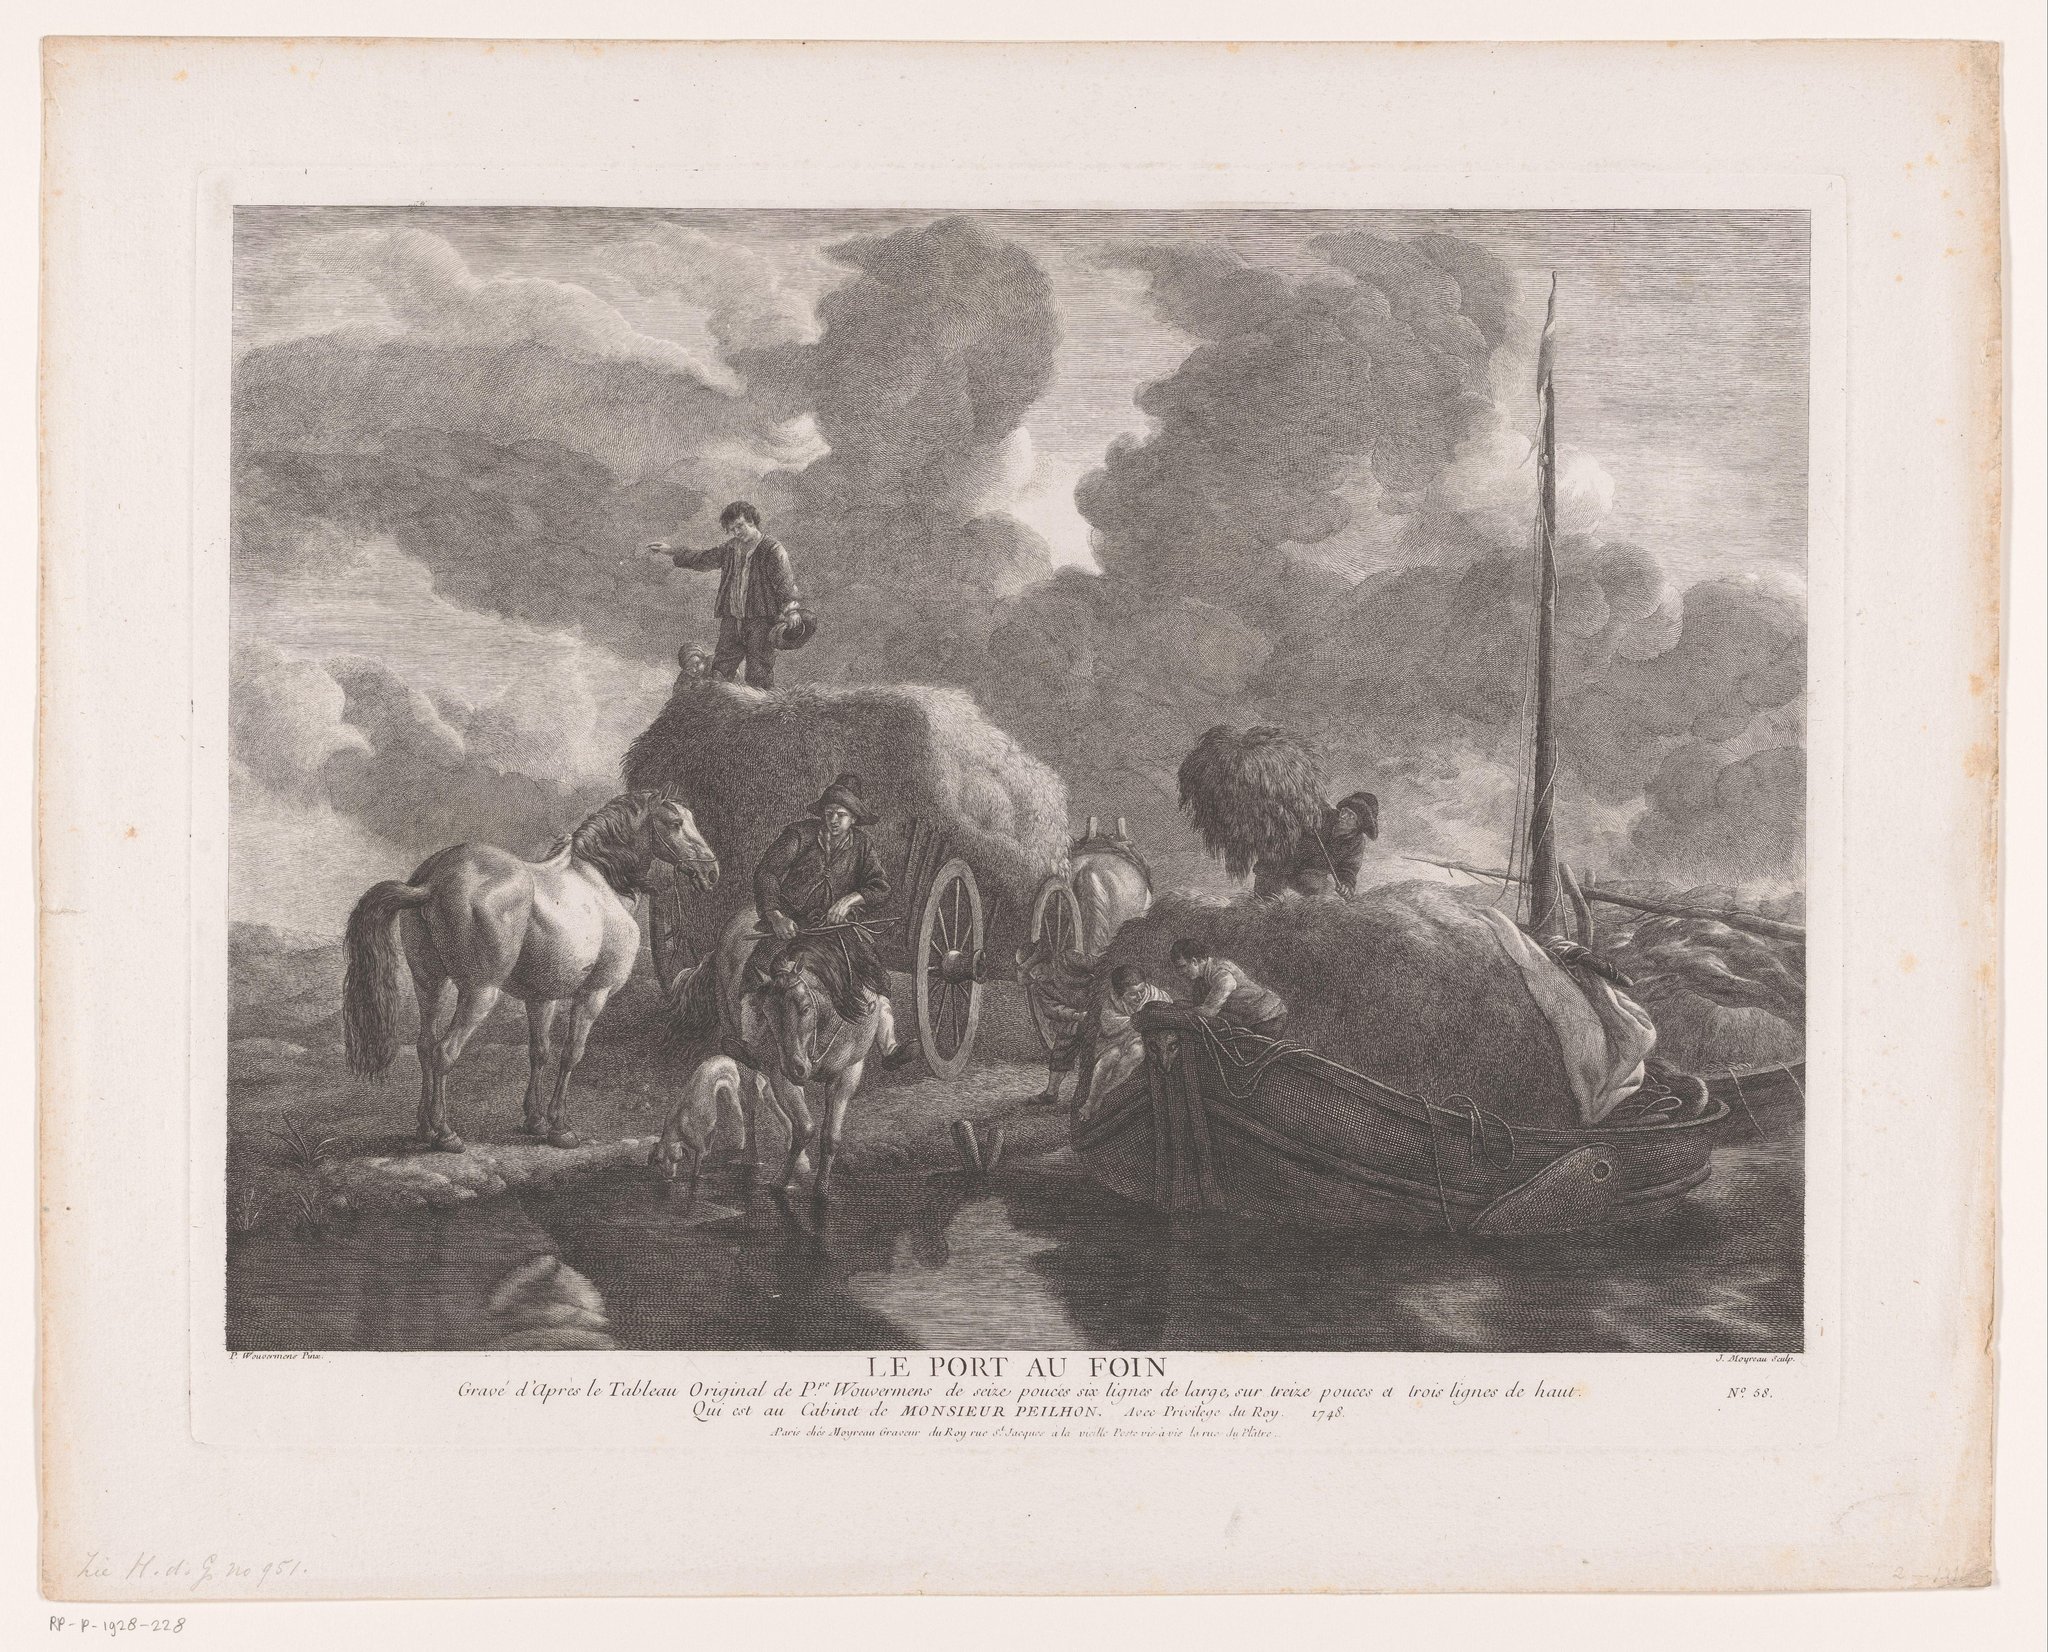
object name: print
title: Oeuvres de Ph.pe Wouwermans Hollandois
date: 1748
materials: paper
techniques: engraving, etching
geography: france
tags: transporting ~ harvest, hay-wagon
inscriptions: collector's mark: Lugt 2228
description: Maakt deel uit van een serie van 89 prenten te dateren tussen ca. 1733-1762, naar het geschilderde oeuvre van Philips Wouwerman.